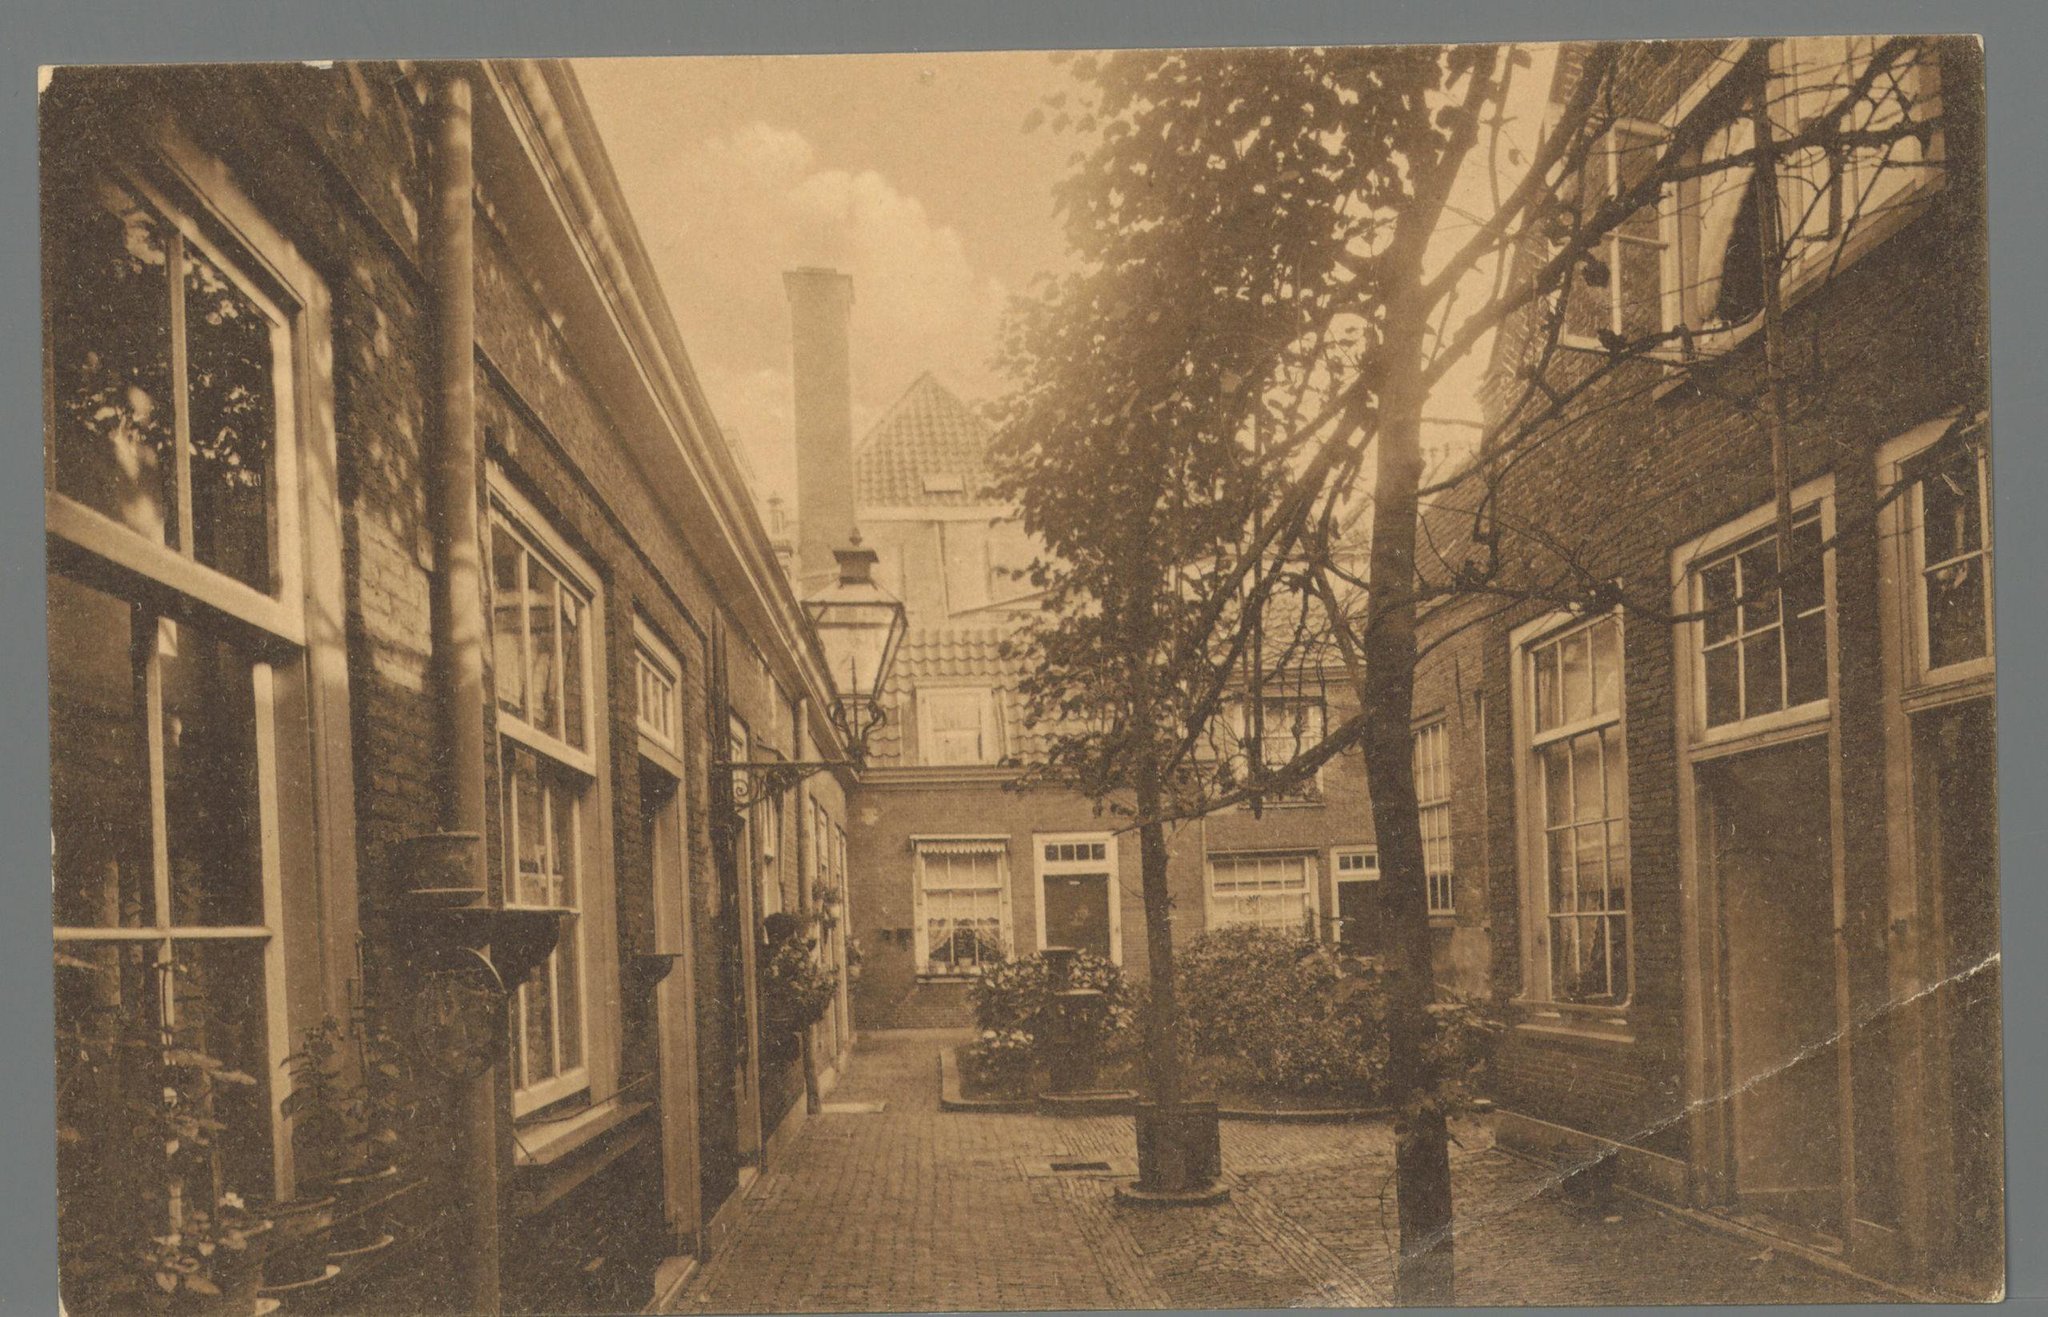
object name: ansichtkaart, prentbriefkaart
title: Leiden. Jean Michelshof - Pieterskerkstraat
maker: Anonymous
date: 1910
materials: cardboard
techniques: photograph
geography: the hague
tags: alms-house (dutch: 'hofje'), street, leiden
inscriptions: date